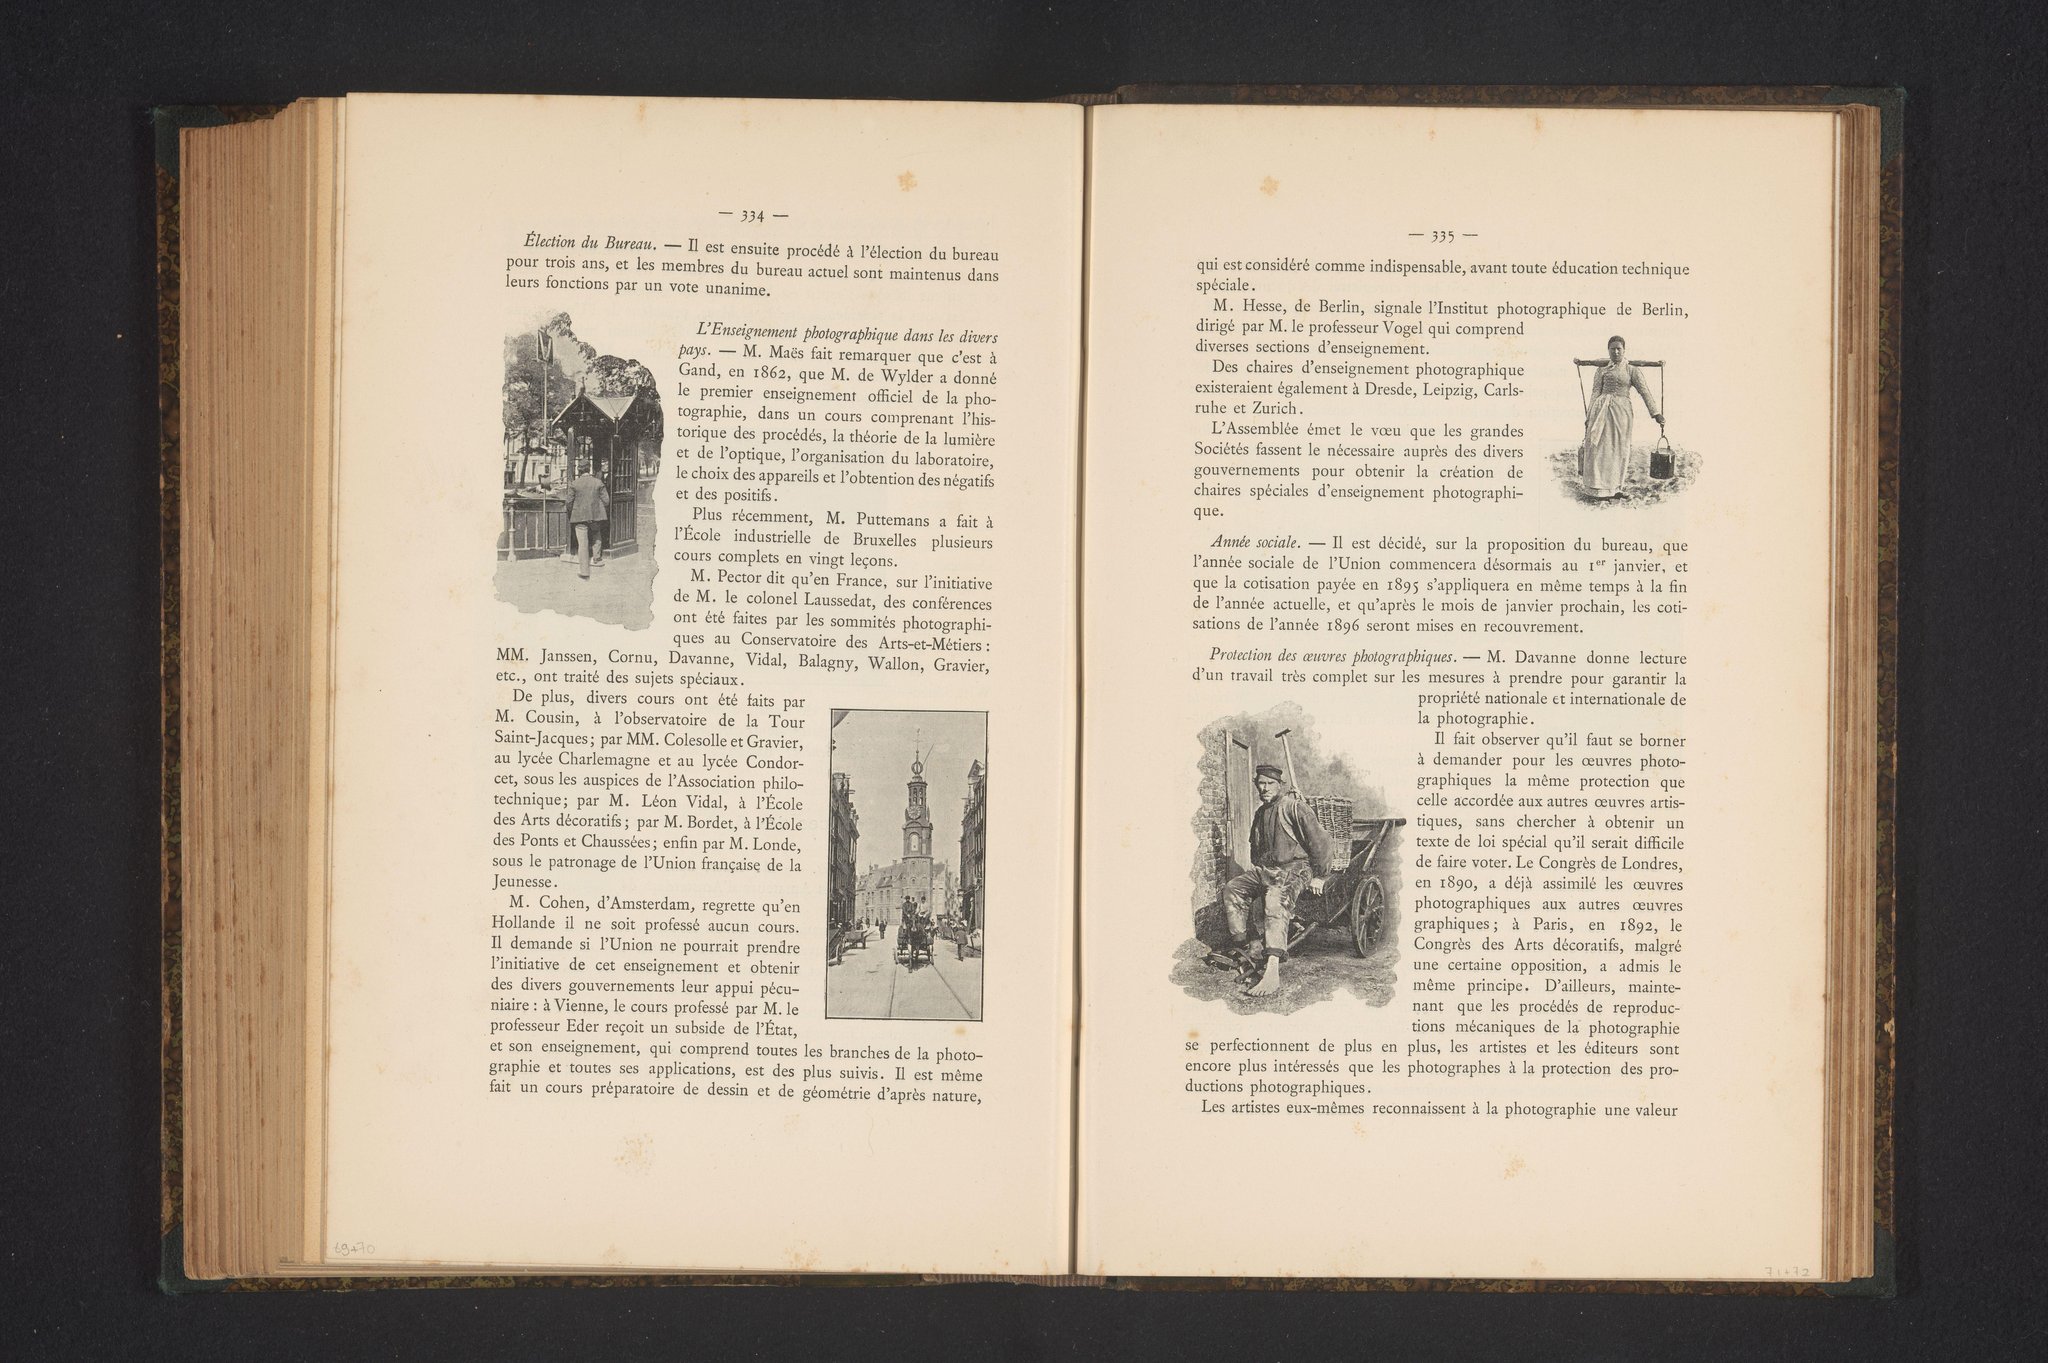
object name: photomechanical print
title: Gezicht op de Munttoren in Amsterdam, met op de voorgrond paard en wagen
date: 1890-1895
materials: paper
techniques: autotype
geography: amsterdam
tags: four-wheeled vehicle drawn by one animal, tower, clock tower ~ monumental adornment, horse